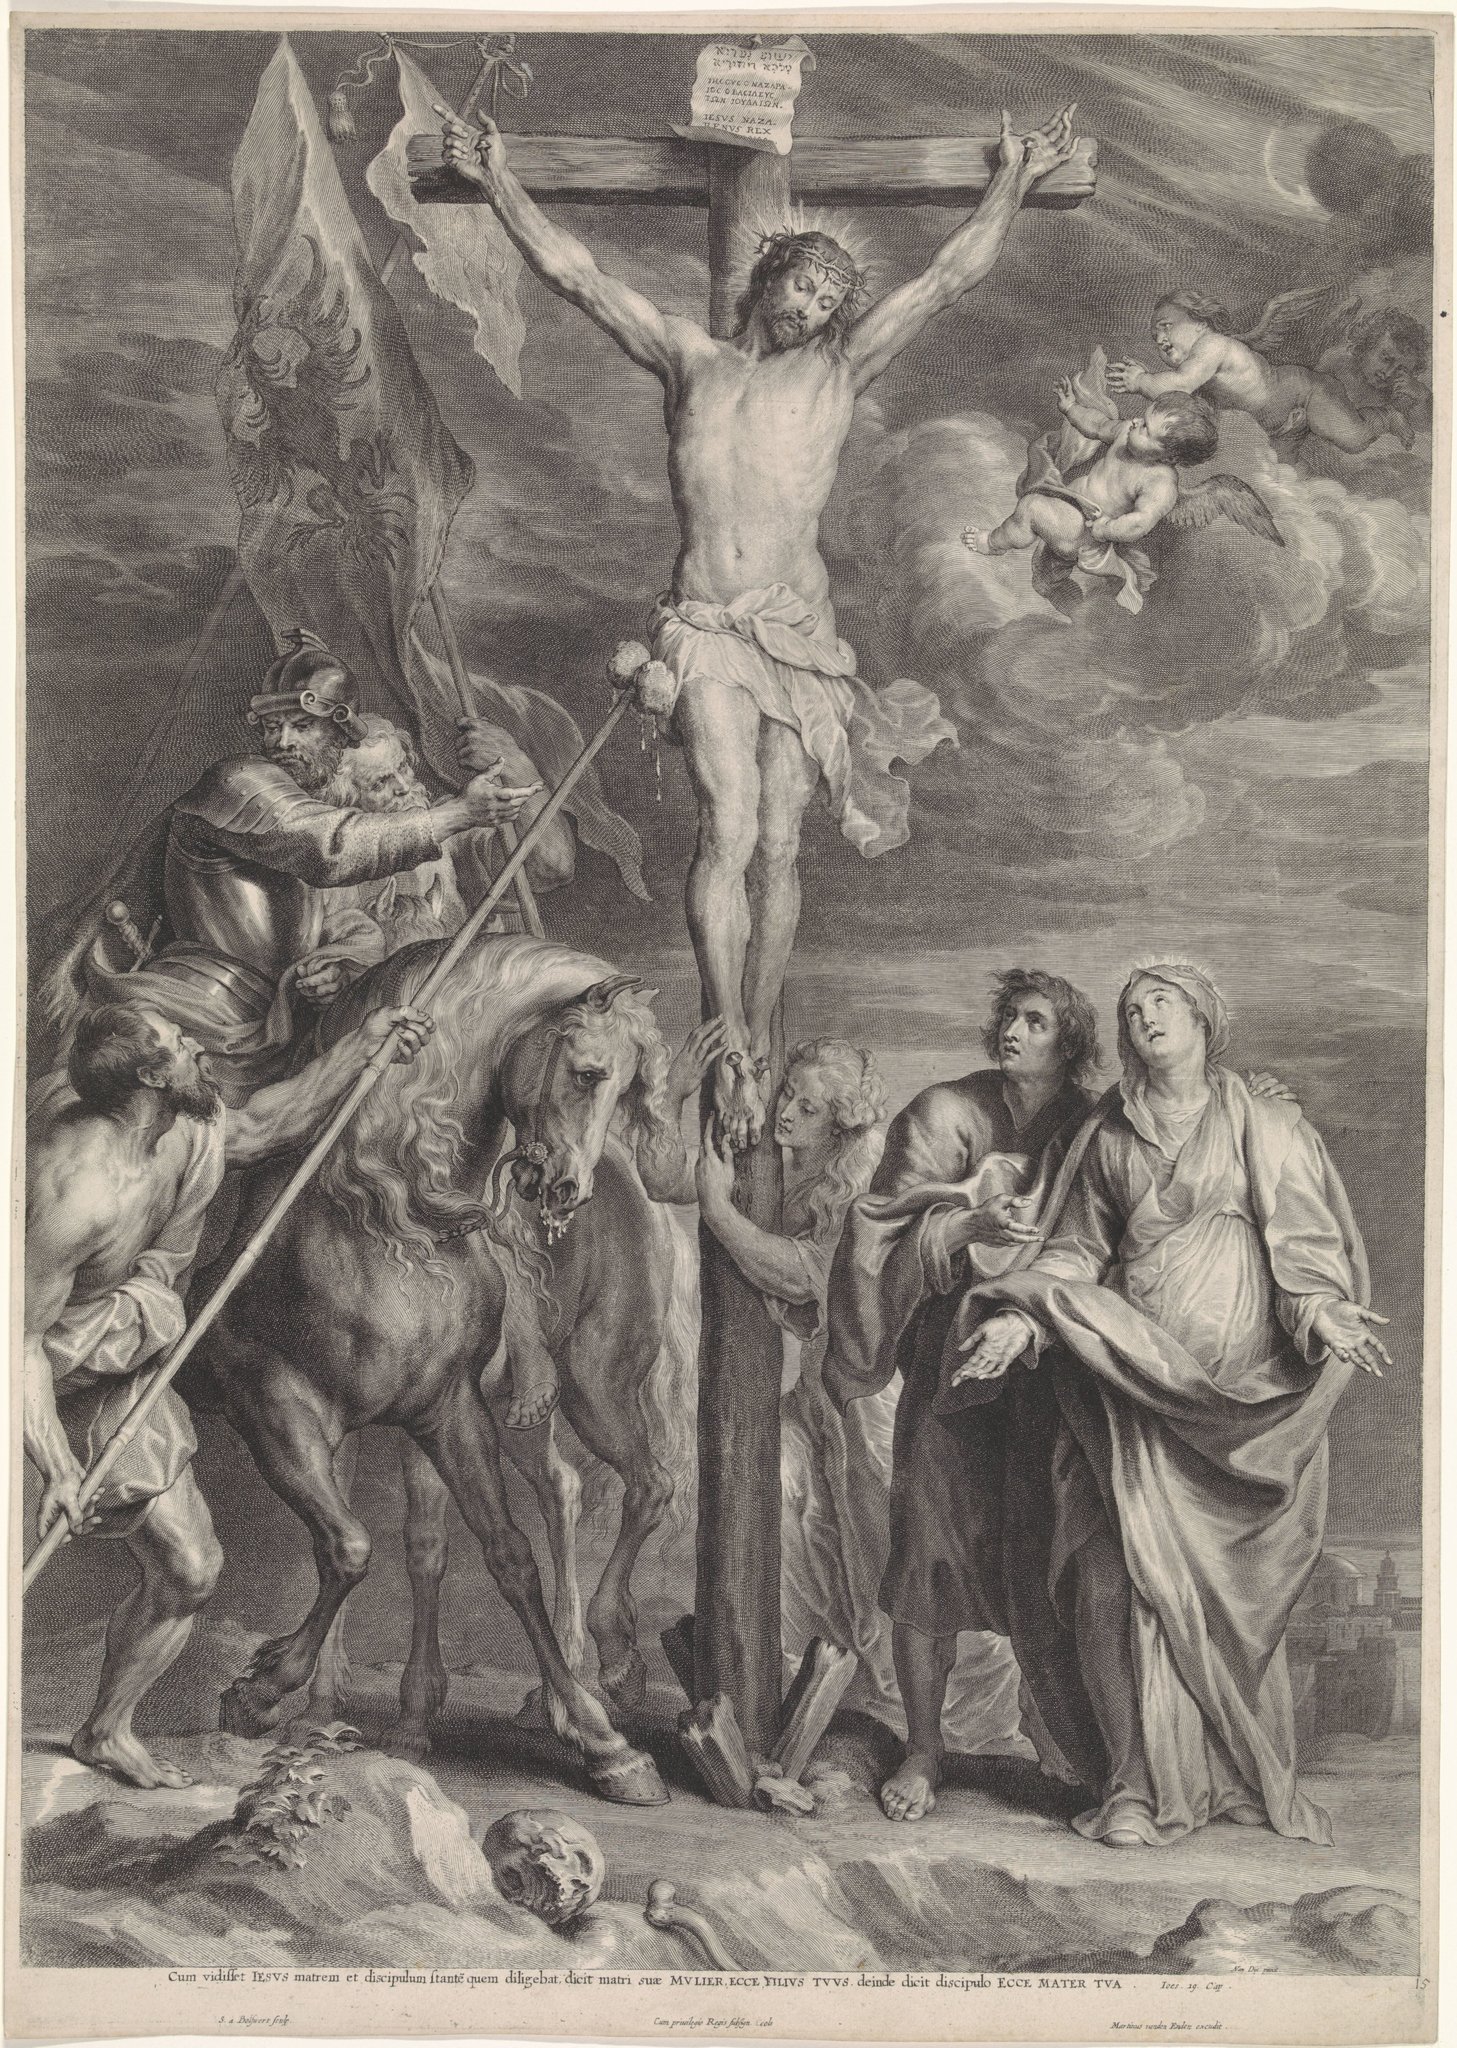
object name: print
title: Christus aan het kruis, met Maria, Johannes, Maria Magdalena en soldaten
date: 1596-1659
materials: paper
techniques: engraving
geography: netherlands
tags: crucified christ with mary, john, and mary magdalene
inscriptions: collector's mark: Lugt 240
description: Christus aan het kruis, met Maria, Johannes, Maria Magdalena en soldaten. In de marge onder staat een fragment uit bijbeltekst Johannes 19.